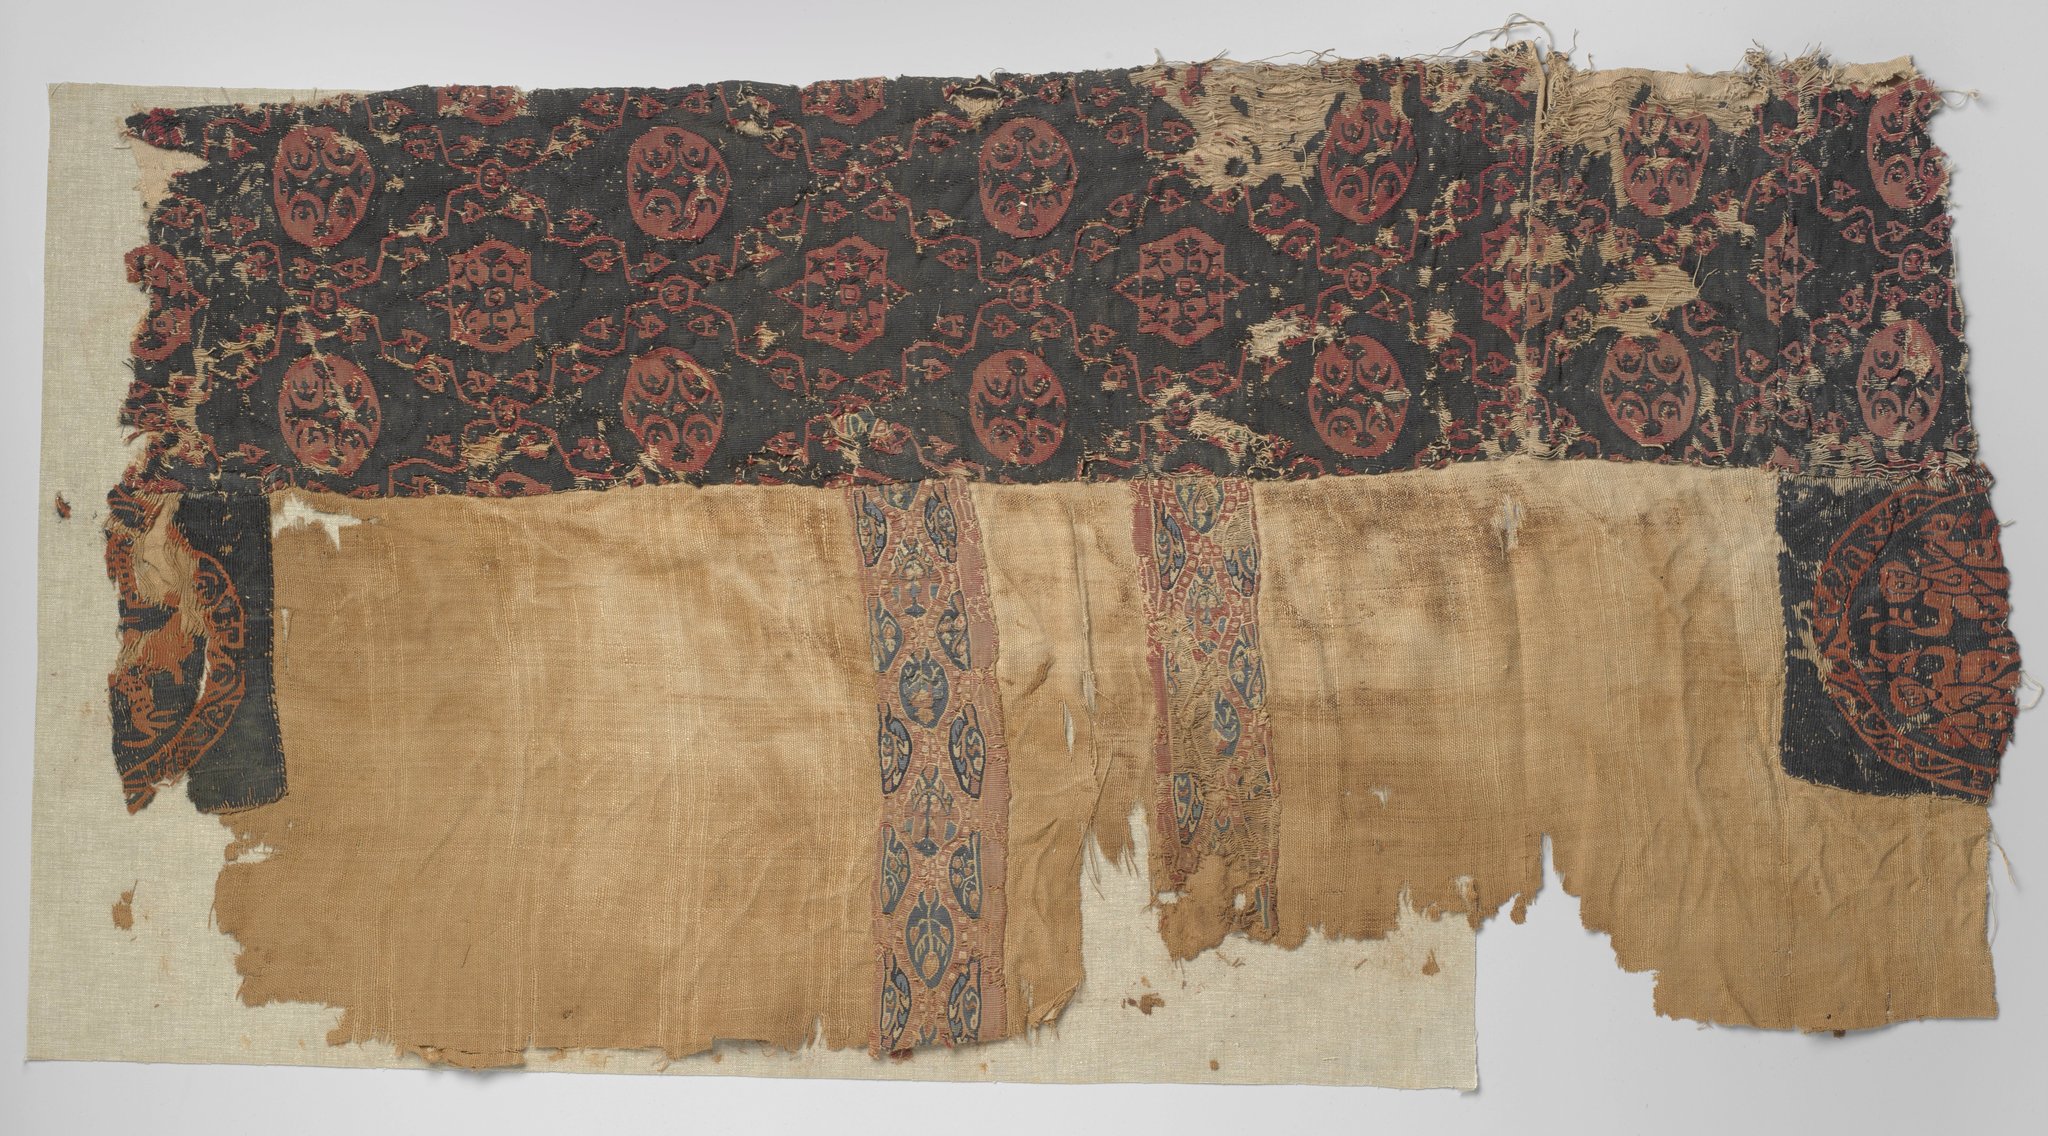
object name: tunicle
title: Fragment van een tunica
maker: Anonymous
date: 500-799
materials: linen, wool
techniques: weave, tapestry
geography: egypt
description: Fragment van een tunica met opgenaaide decoraties bestaande uit twee tabulae, twee clavi en twee aan elkaar genaaide brede banden. De opgenaaide onderdelen hebben verschillende decoraties. Tabulae: donkerblauwe grond met rood twee ruiters met nimbus en opgeheven hand in een cirkel met bladranken. Clavi: rode grond met repeterend motief van geschrankt geplaatste bloemtakken in rood, oranje, blauw, geel en groen op donkerblauwe grond in ovaal. Daartussen slingerlijn met witte stippen, langs één kant een rand met witte lijnmotieven. Brede banden: Donkerblauwe grond met ruiten vormend slingermotief met daarbinnen afwisselend een cirkel en een achthoek met gestileerd motief. In het ondergrondweefsel zijn op negen plekken drie strepen geweven met behulp van een dikkere inslag.